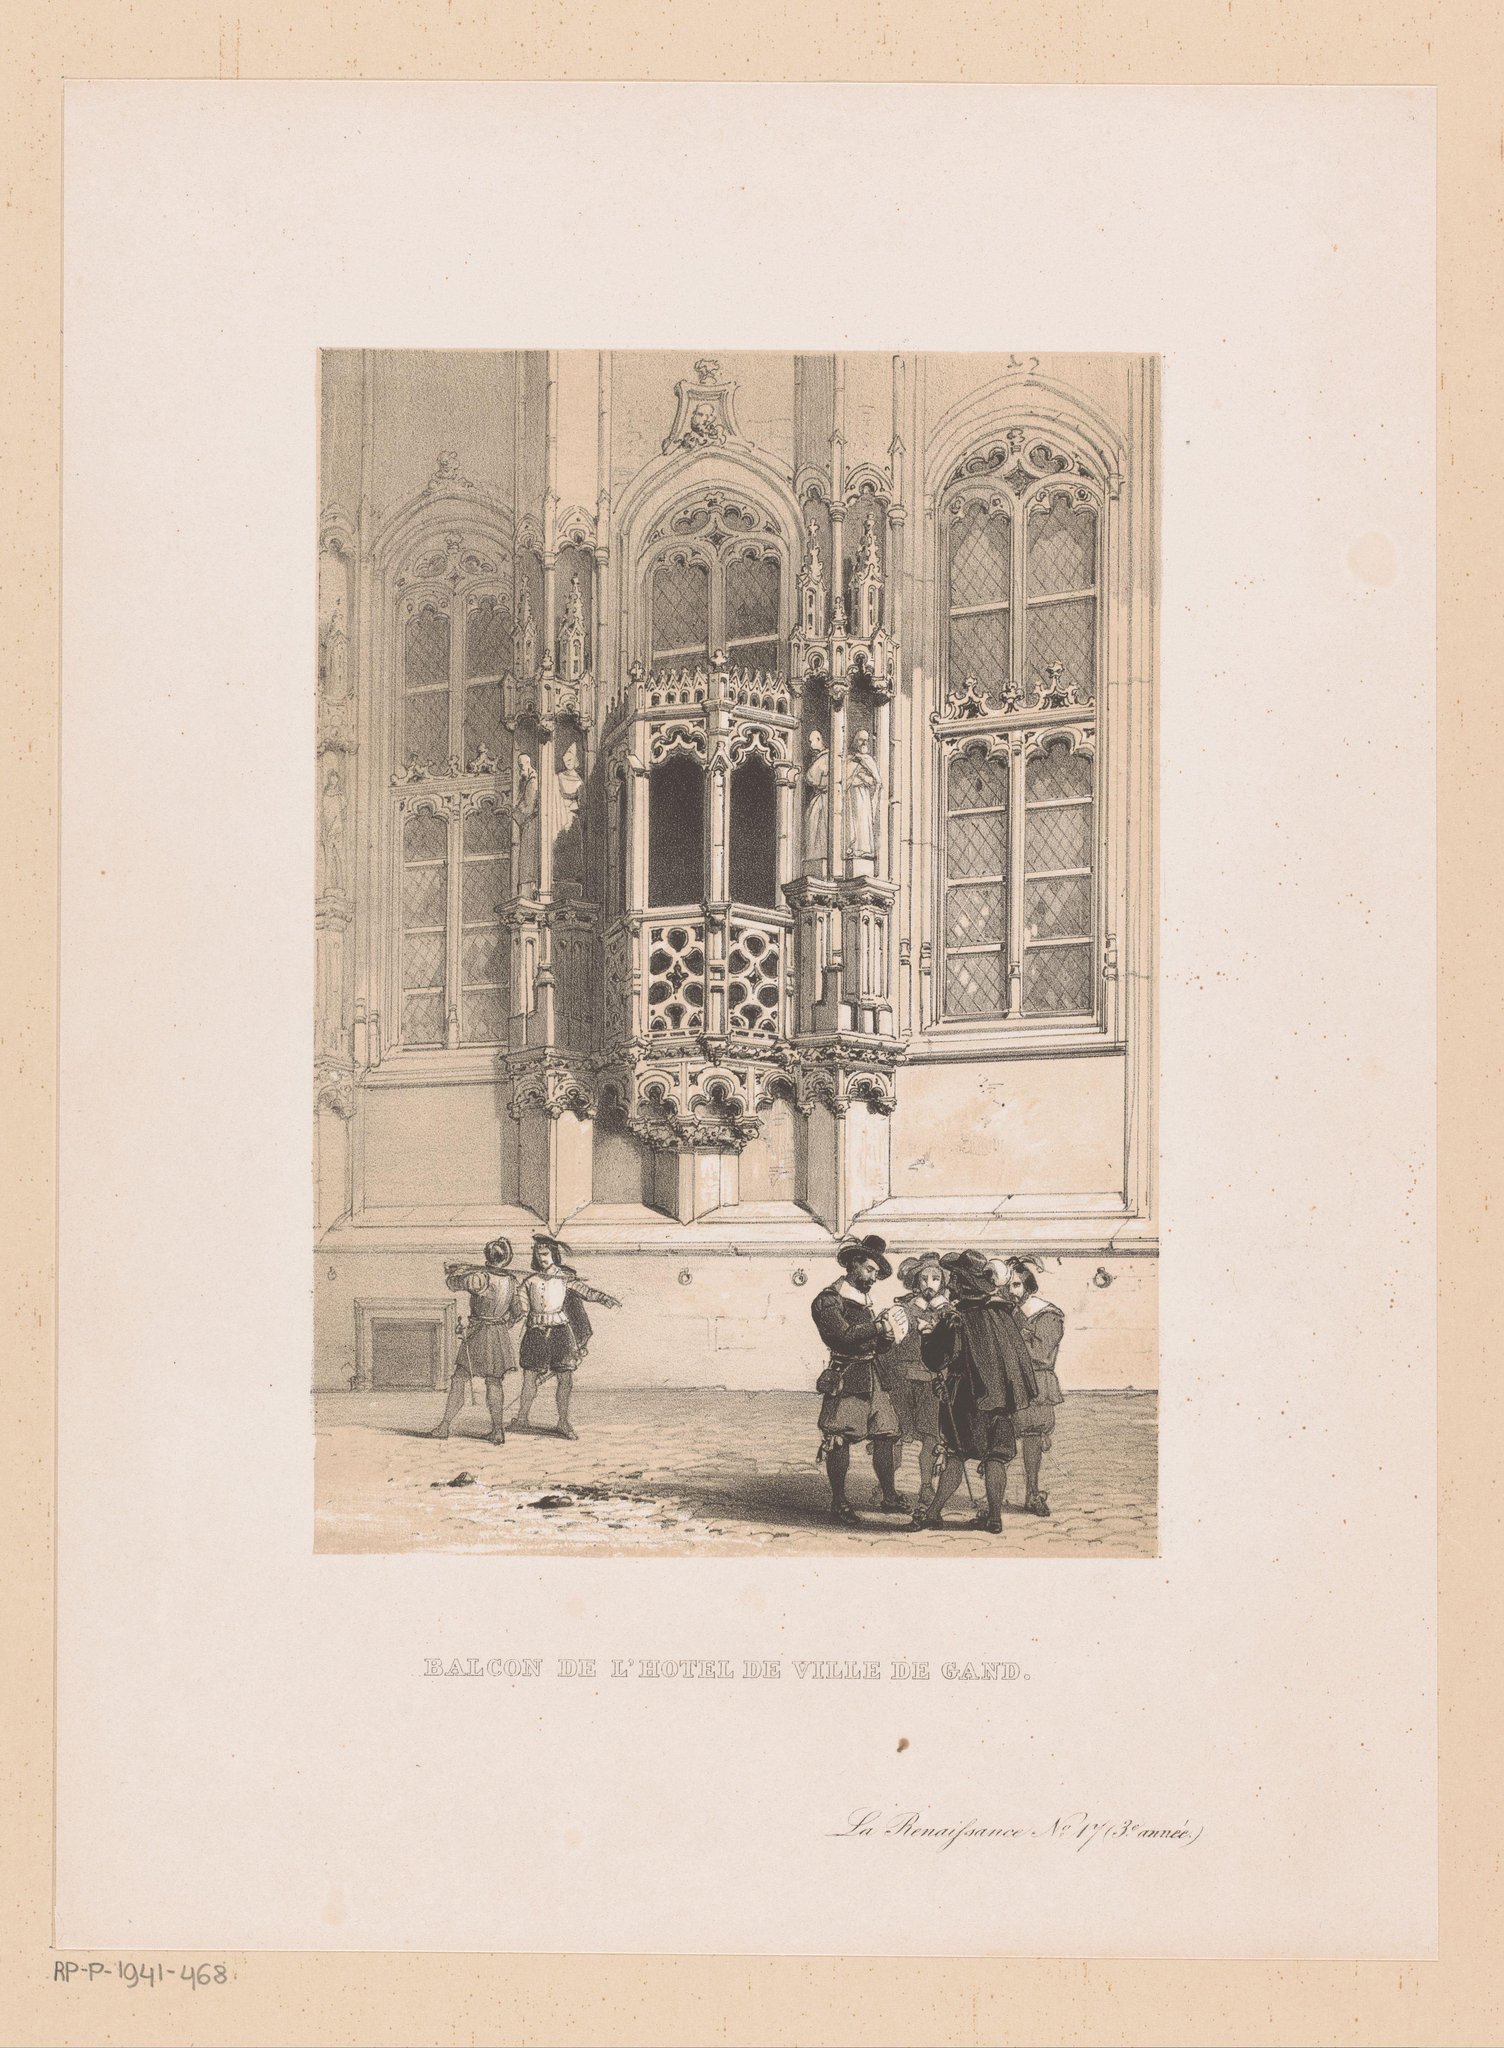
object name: print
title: Balcon de l'Hotel de Ville de Gand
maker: paulus lauters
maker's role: print maker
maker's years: 1806-1875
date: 1841-1842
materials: paper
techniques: tone lithography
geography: brussels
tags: townhall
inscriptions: collector's mark: Lugt 2228, collector's mark: Lugt 2760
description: Prent uit: La Renaissance. Chronique des arts et de la littérature 3 (1841-1842), pl. 17.